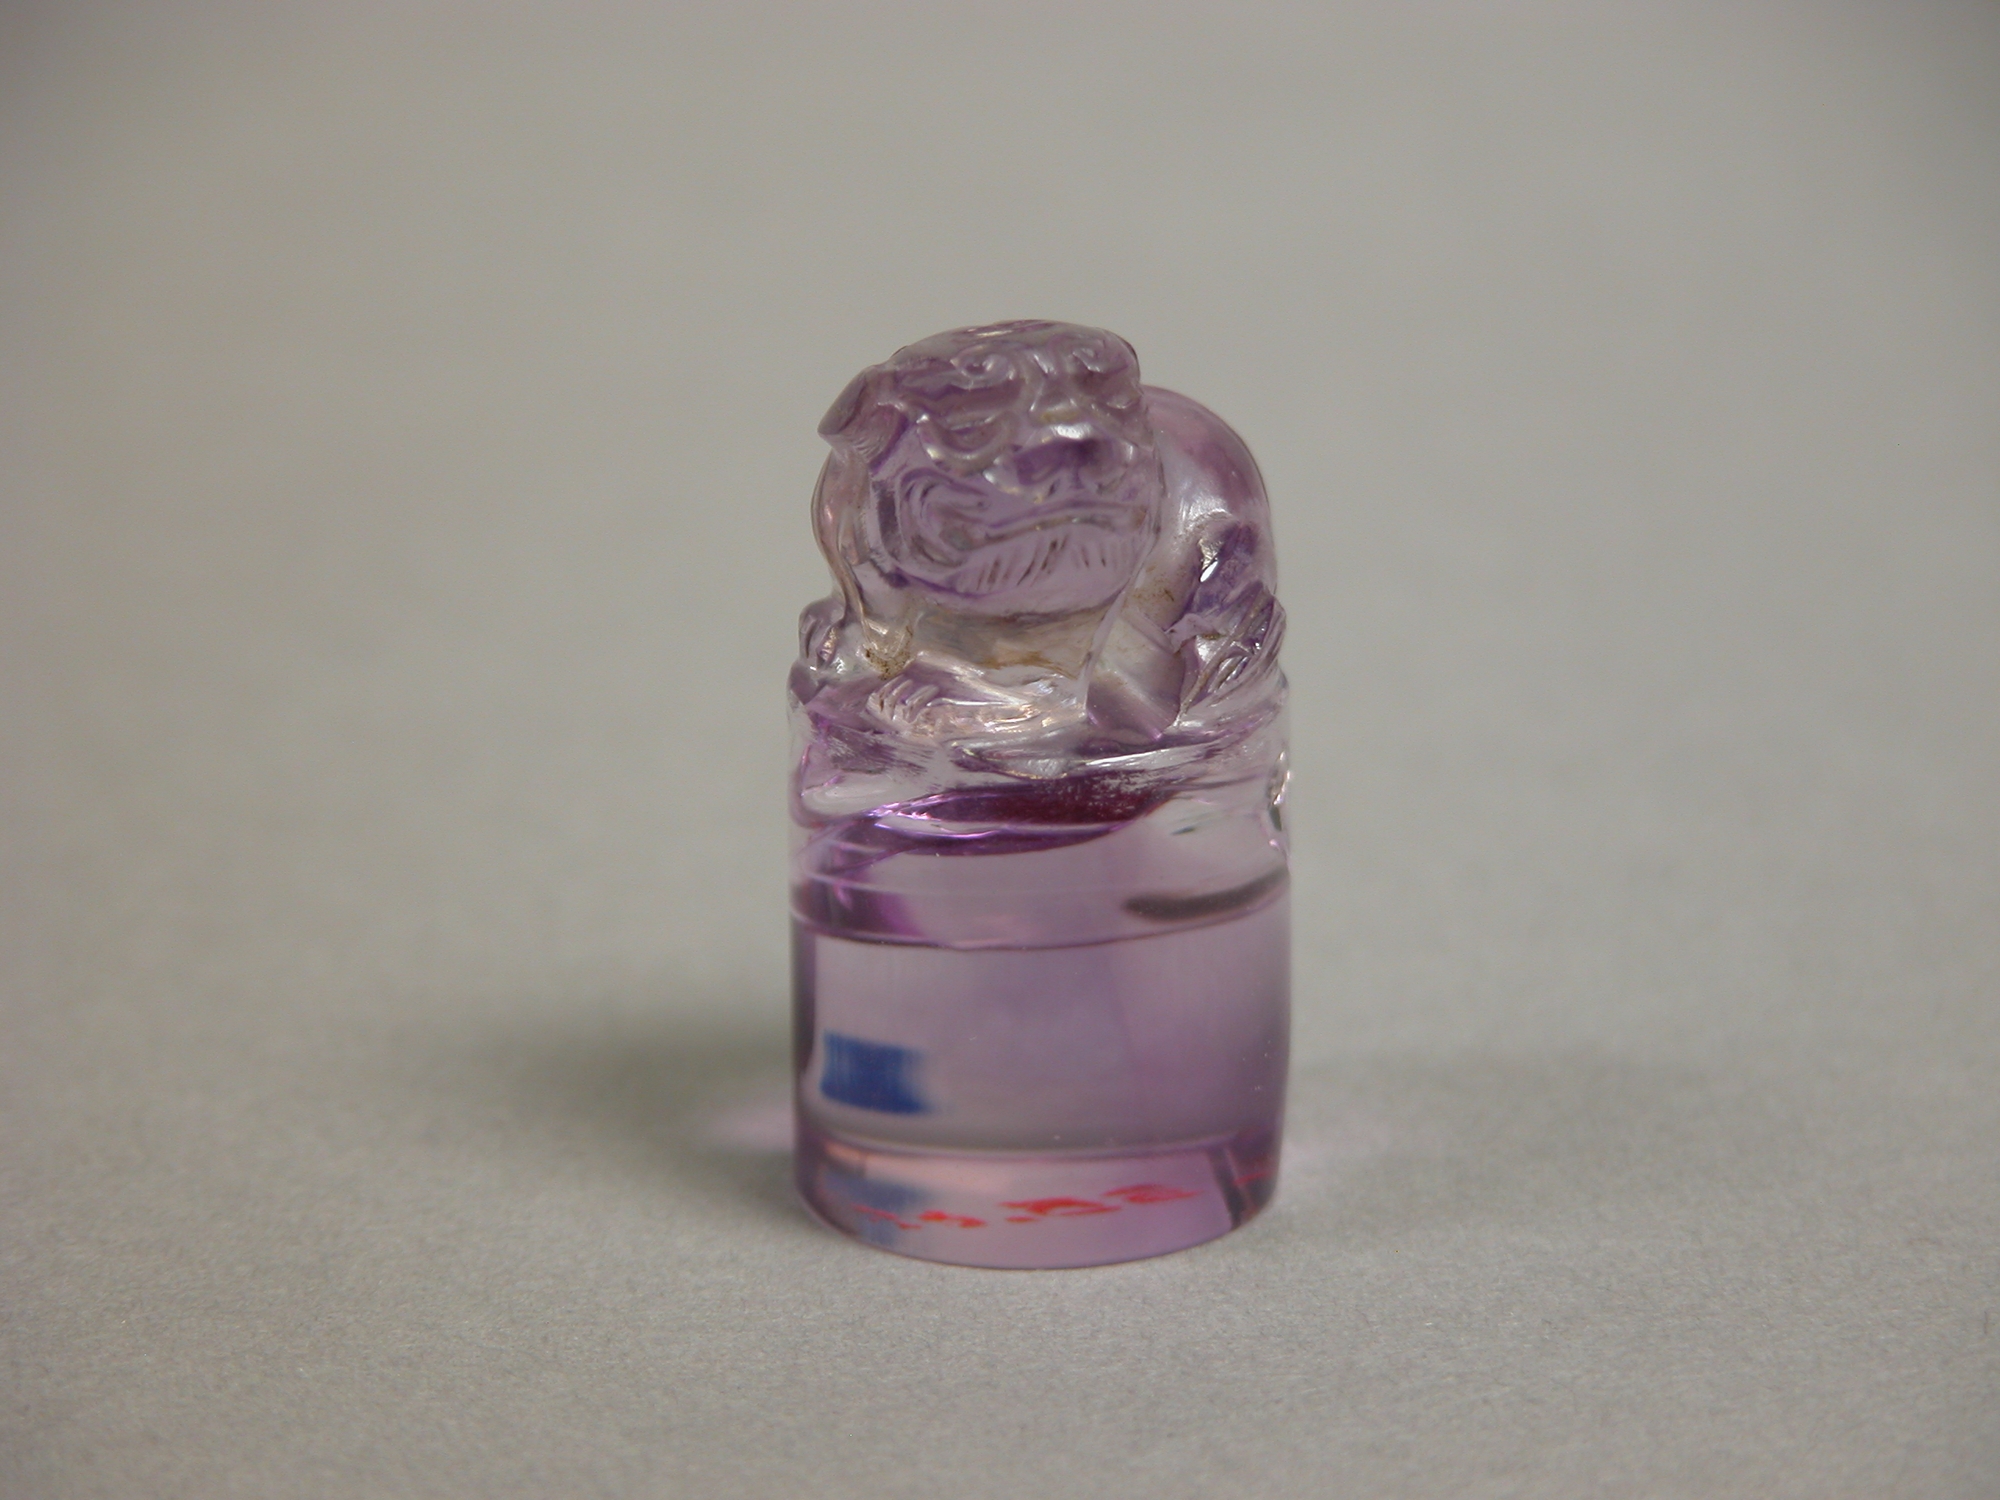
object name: seal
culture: chinese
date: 1867-1933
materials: gemstone